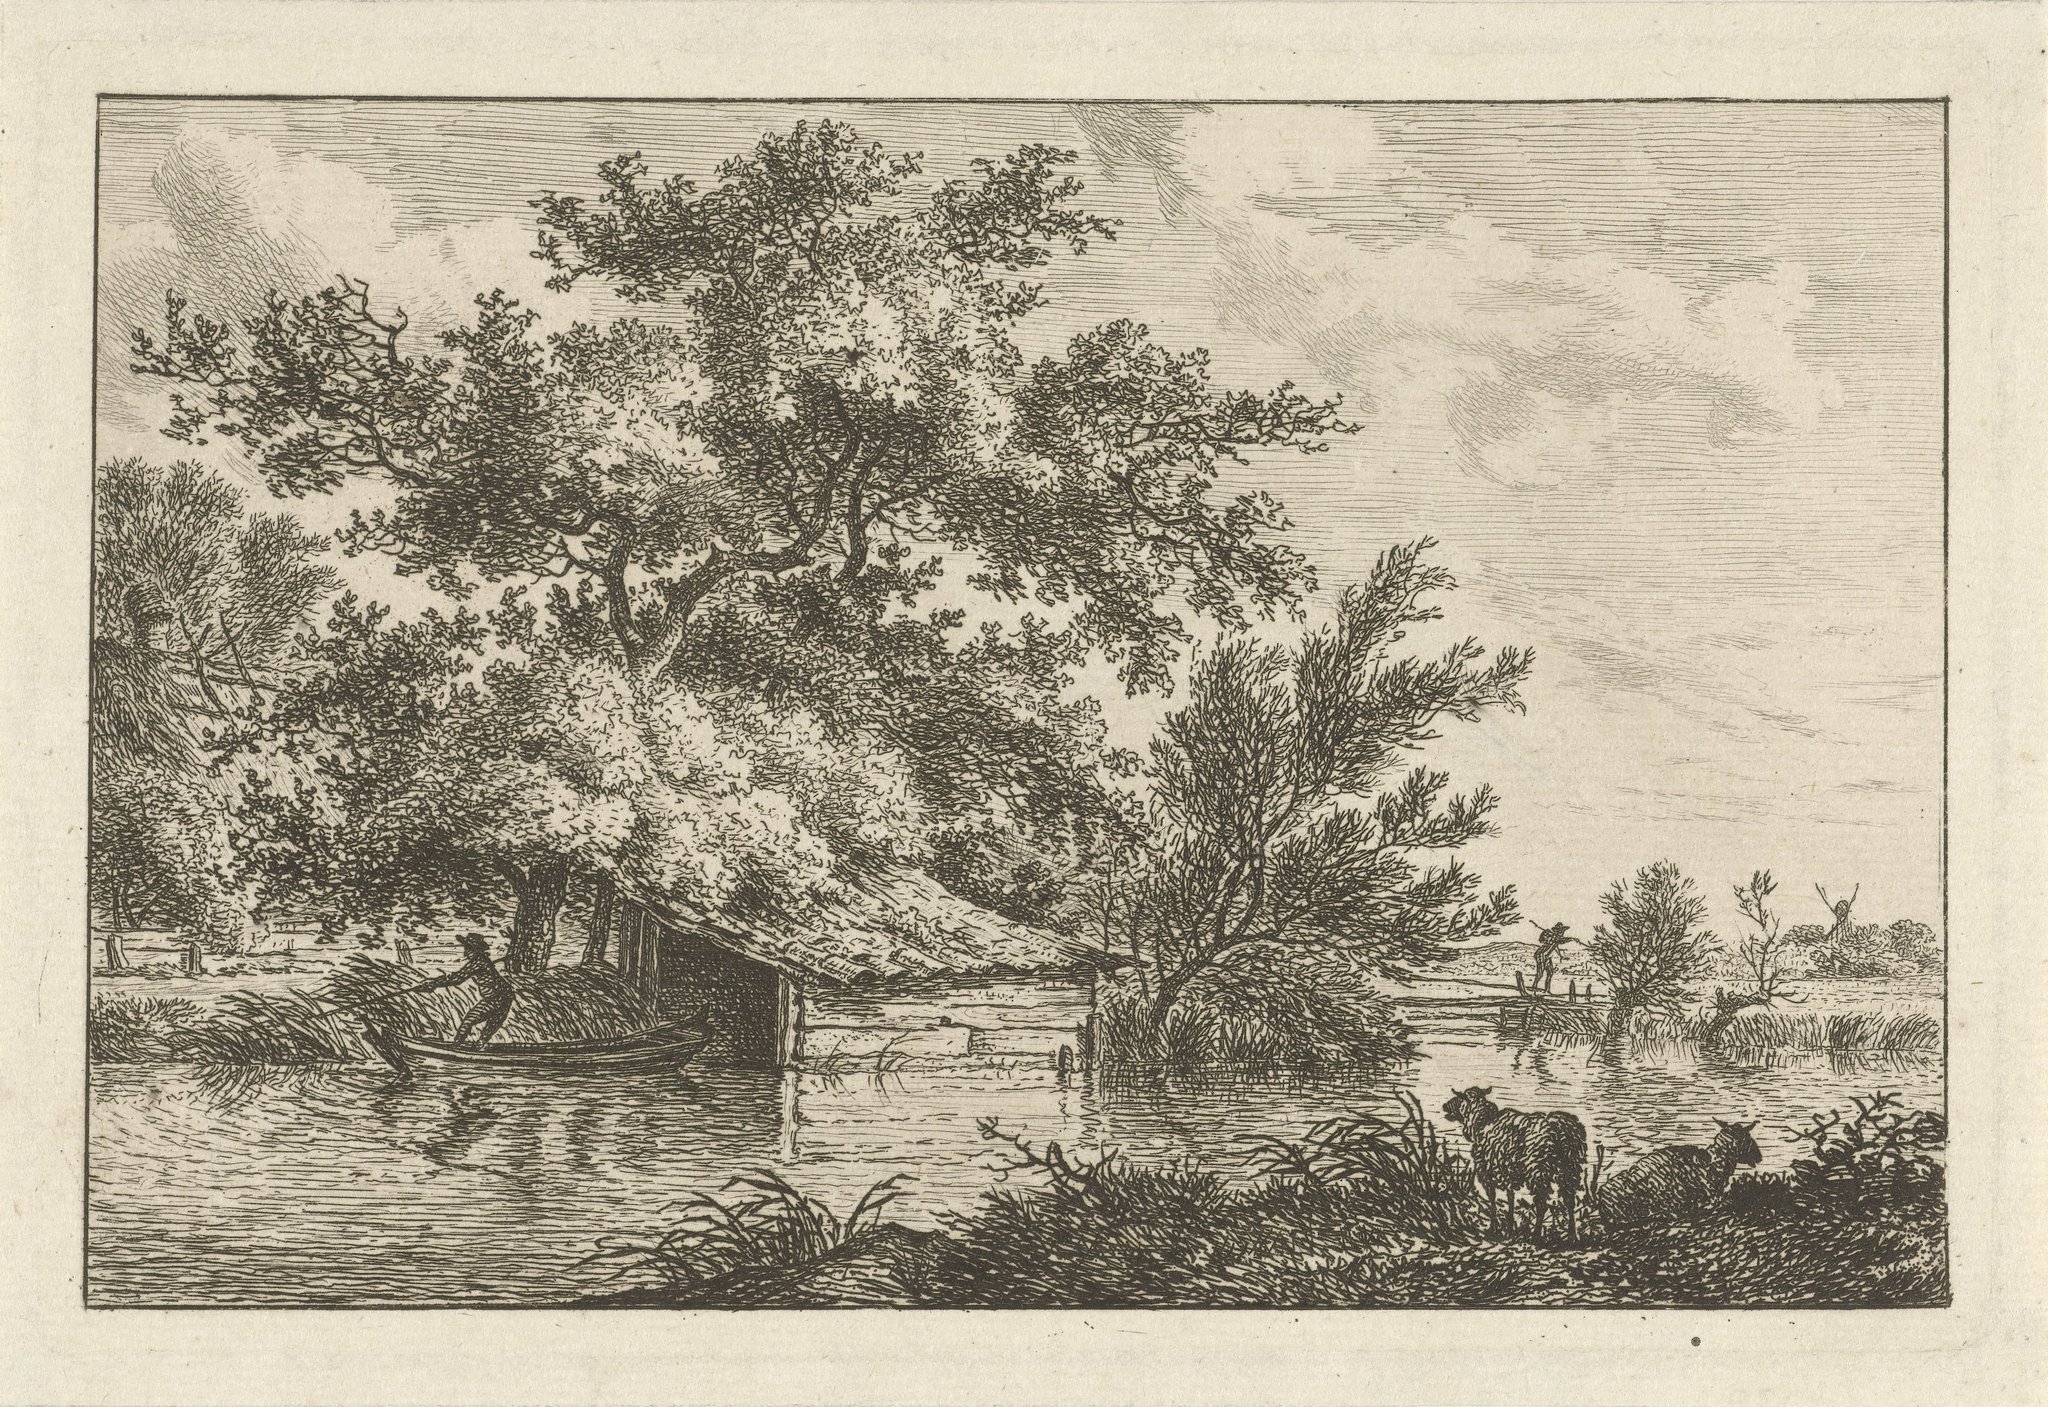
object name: print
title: Schuitje bij boothuis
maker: hermanus fock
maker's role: conservator, draughtsman, painter, print maker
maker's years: 1766-1822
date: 1781-1822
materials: paper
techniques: etching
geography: amsterdam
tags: river (+ landscape with figures, staffage), boat-house, shed (+ exterior ~ vehicle, ship, etc.)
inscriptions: collector's mark: Lugt 2228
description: Rivierlandschap met een roeiboot bij een klein boothuis. Op de oever op voorgrond twee schapen. Op de achtergrond een wandelaar bij een knotwilg.